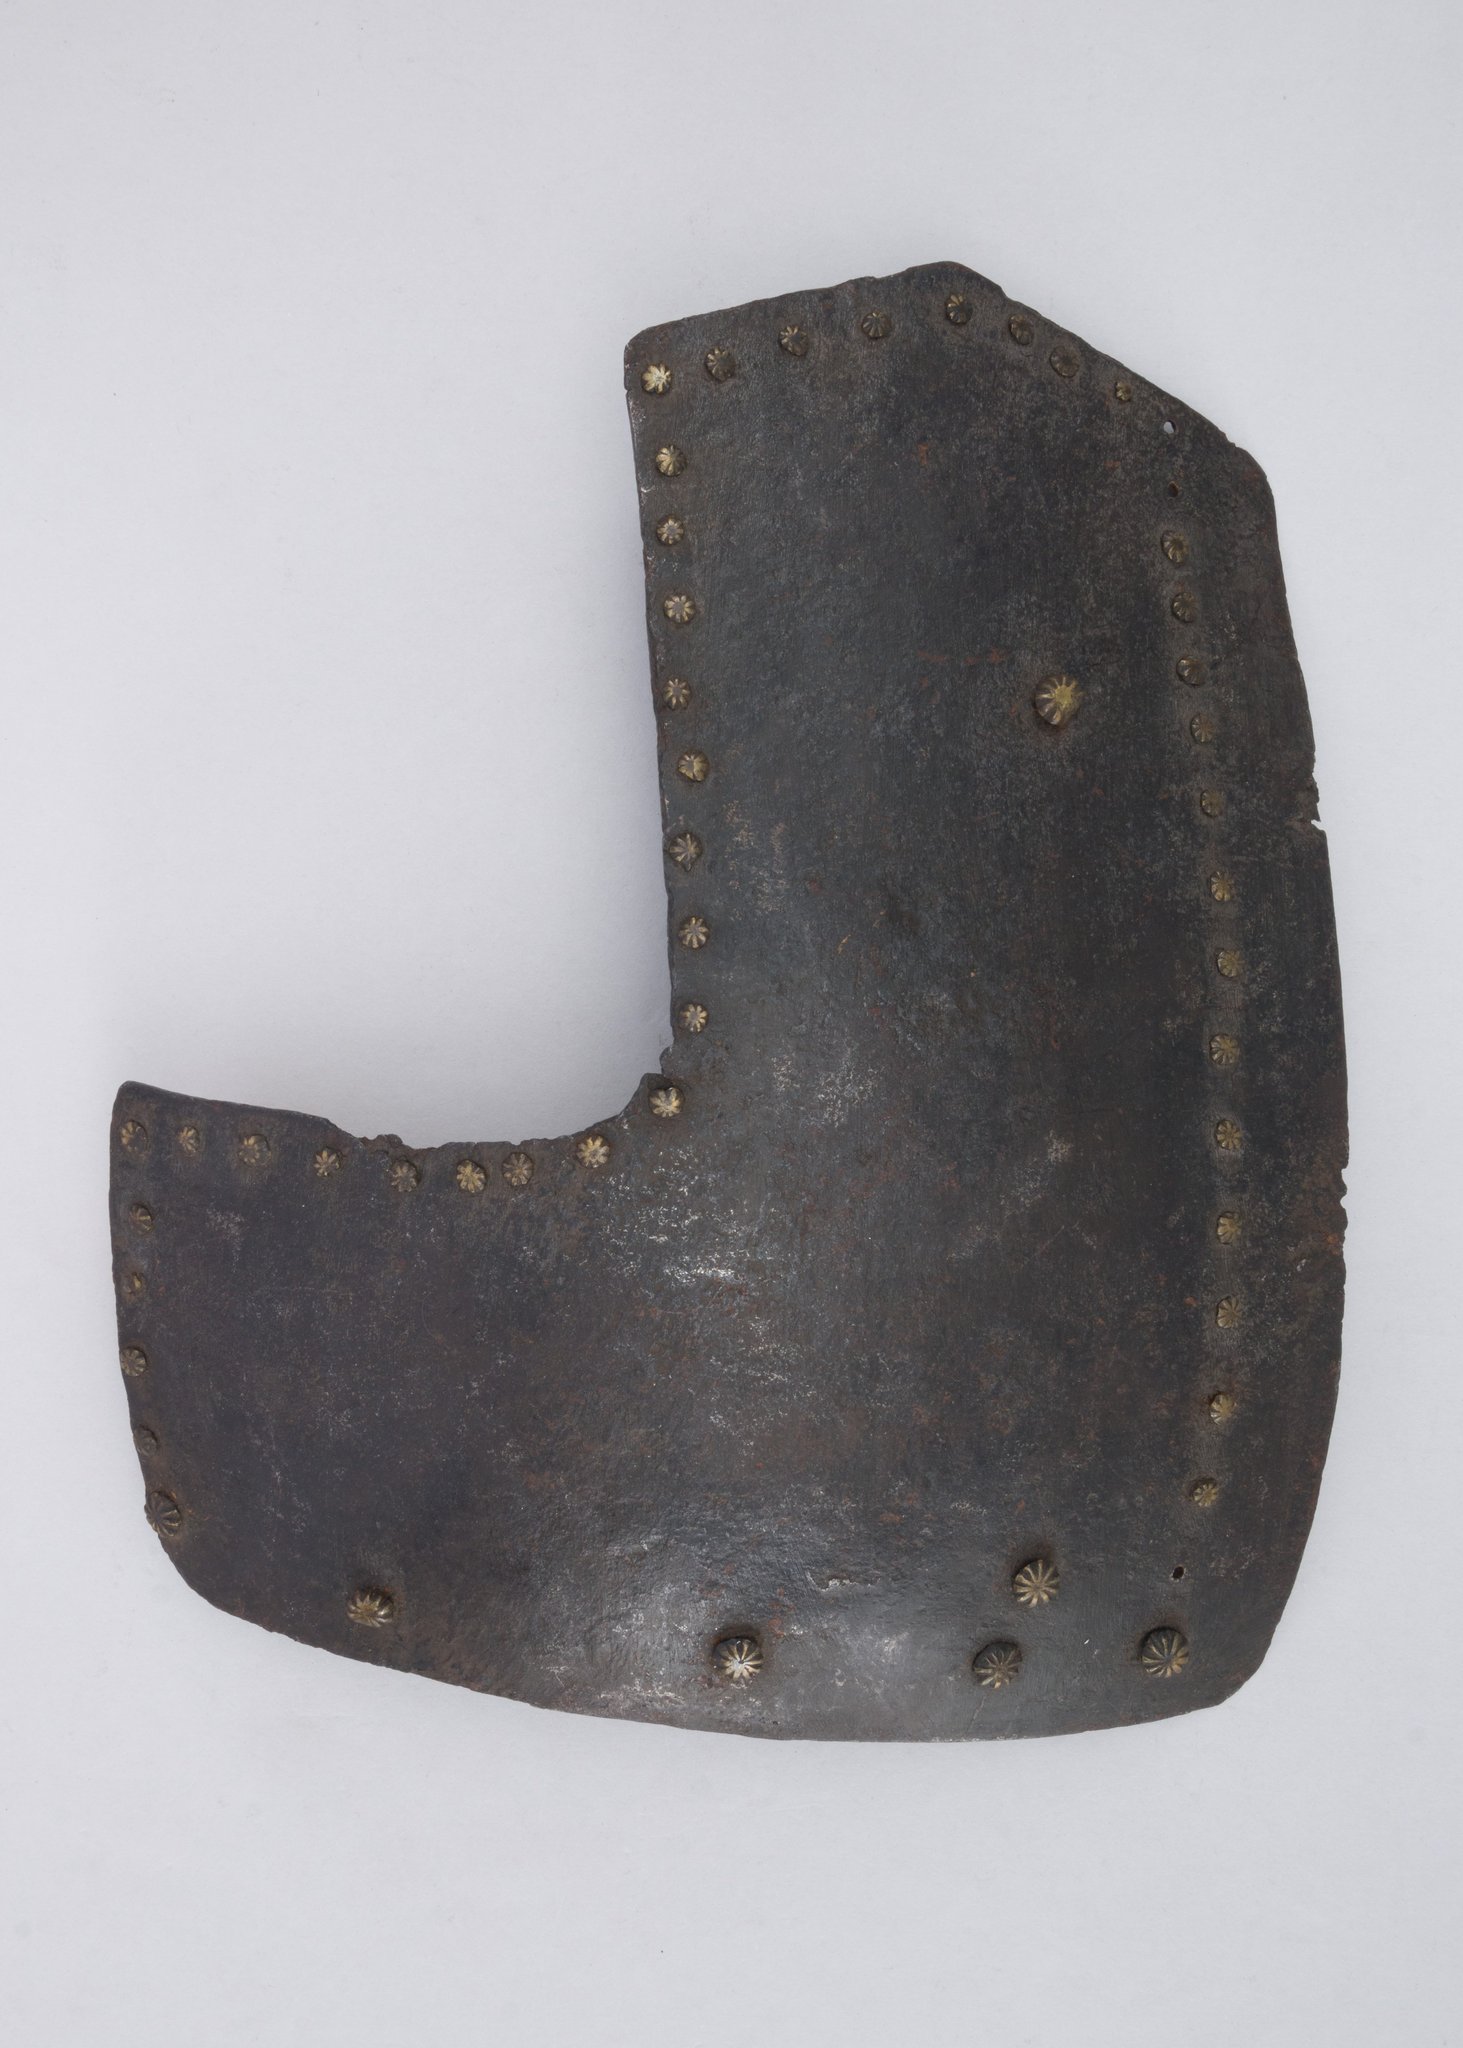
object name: brigandine plate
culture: italian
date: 1400-1450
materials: copper alloy, metal alloy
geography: italy